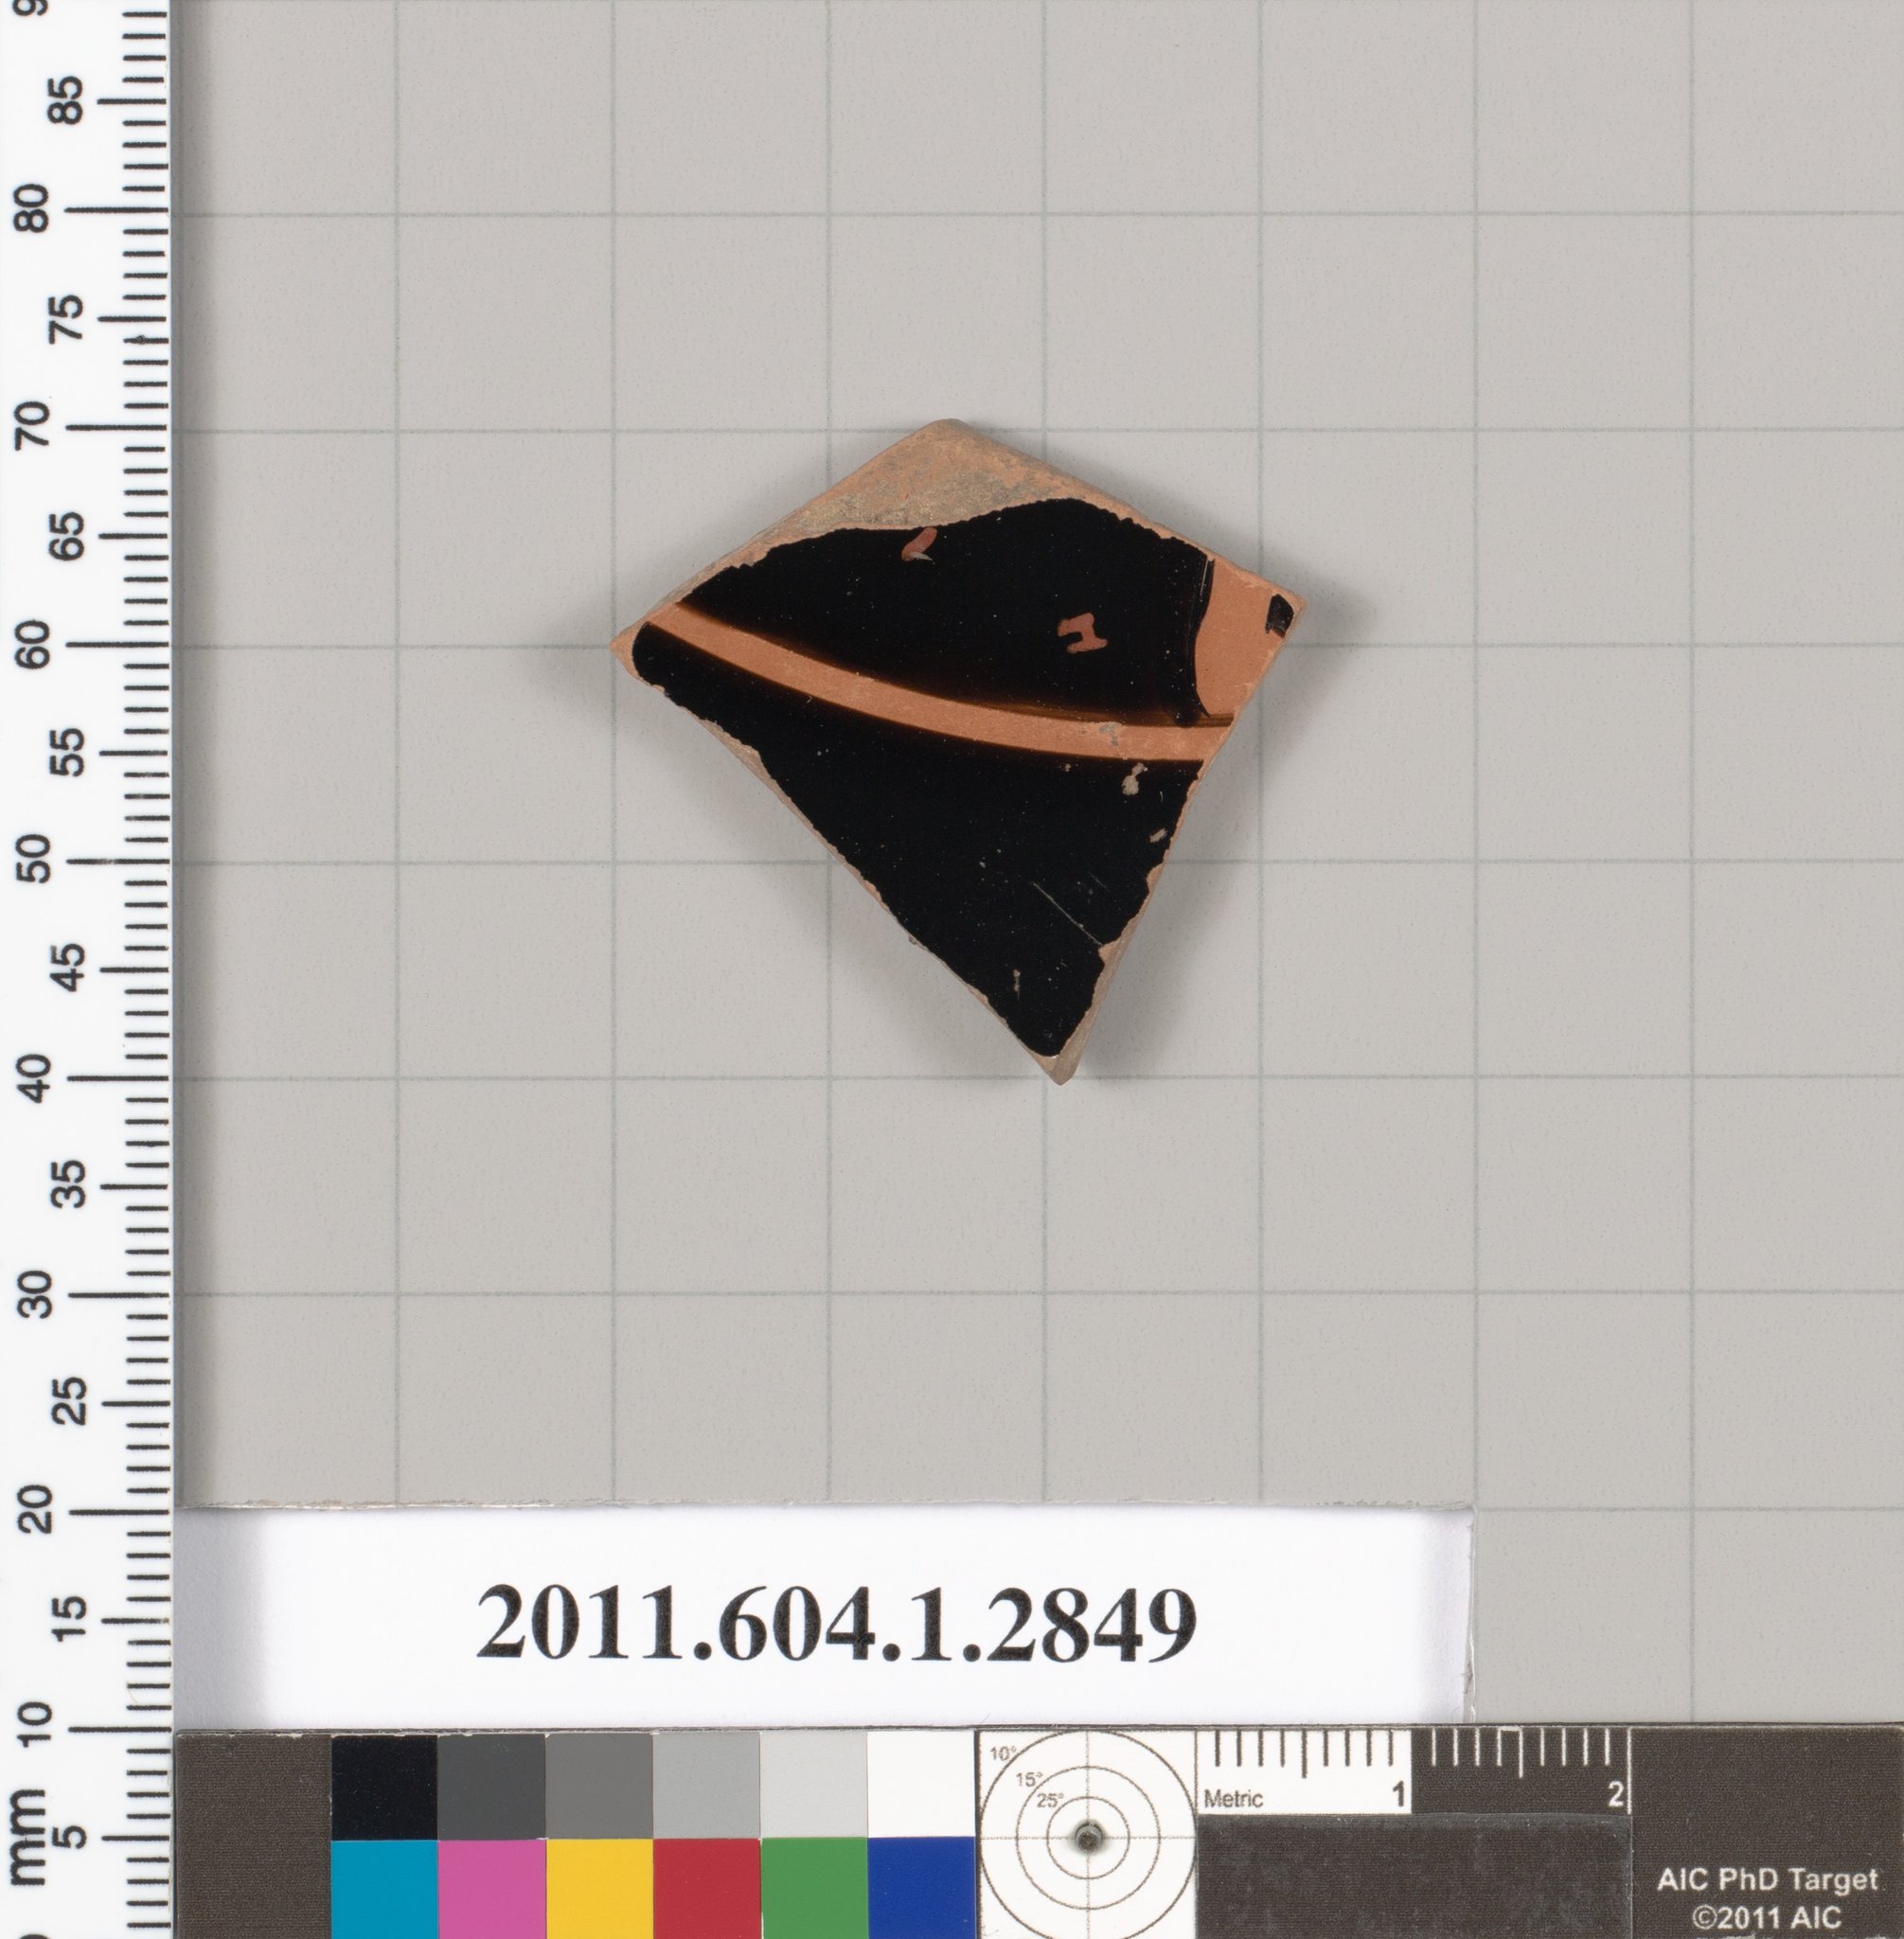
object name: kylix fragment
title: Terracotta fragment of a kylix (drinking cup)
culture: greek, attic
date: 520-490 BCE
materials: terracotta